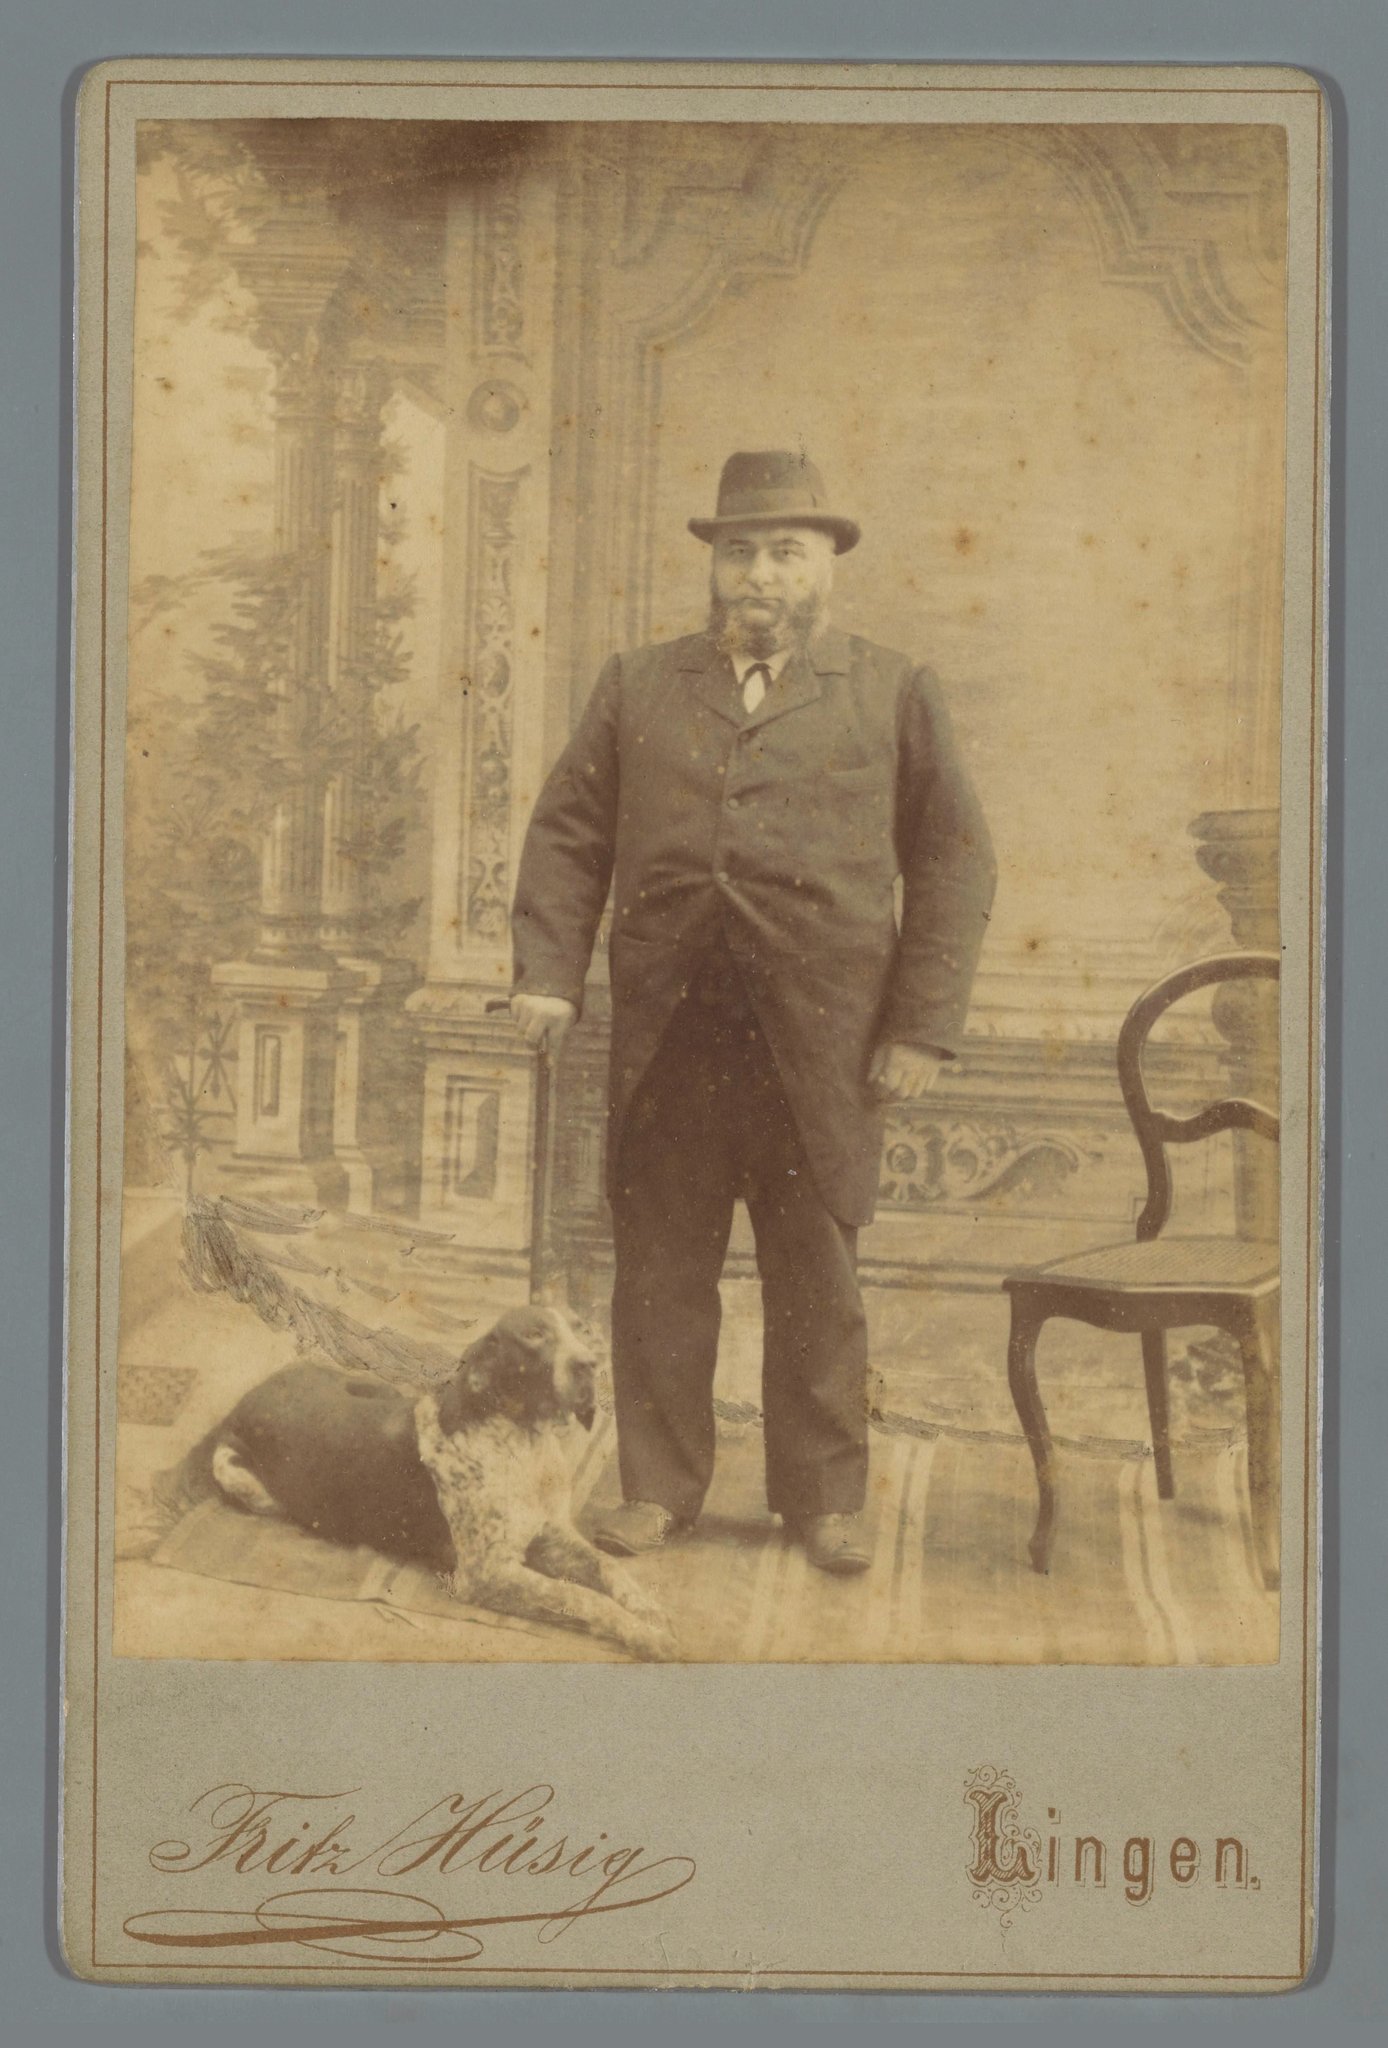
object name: cabinet photograph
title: Portret van een onbekende man met een hond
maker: fritz hüsig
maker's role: fotograaf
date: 1875-1899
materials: cardboard, photographic support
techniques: albumen print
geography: lingen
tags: adult man, head-gear: hat, dog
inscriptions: name: ‘Fritz Hüstig Photograph Lingen (...)’